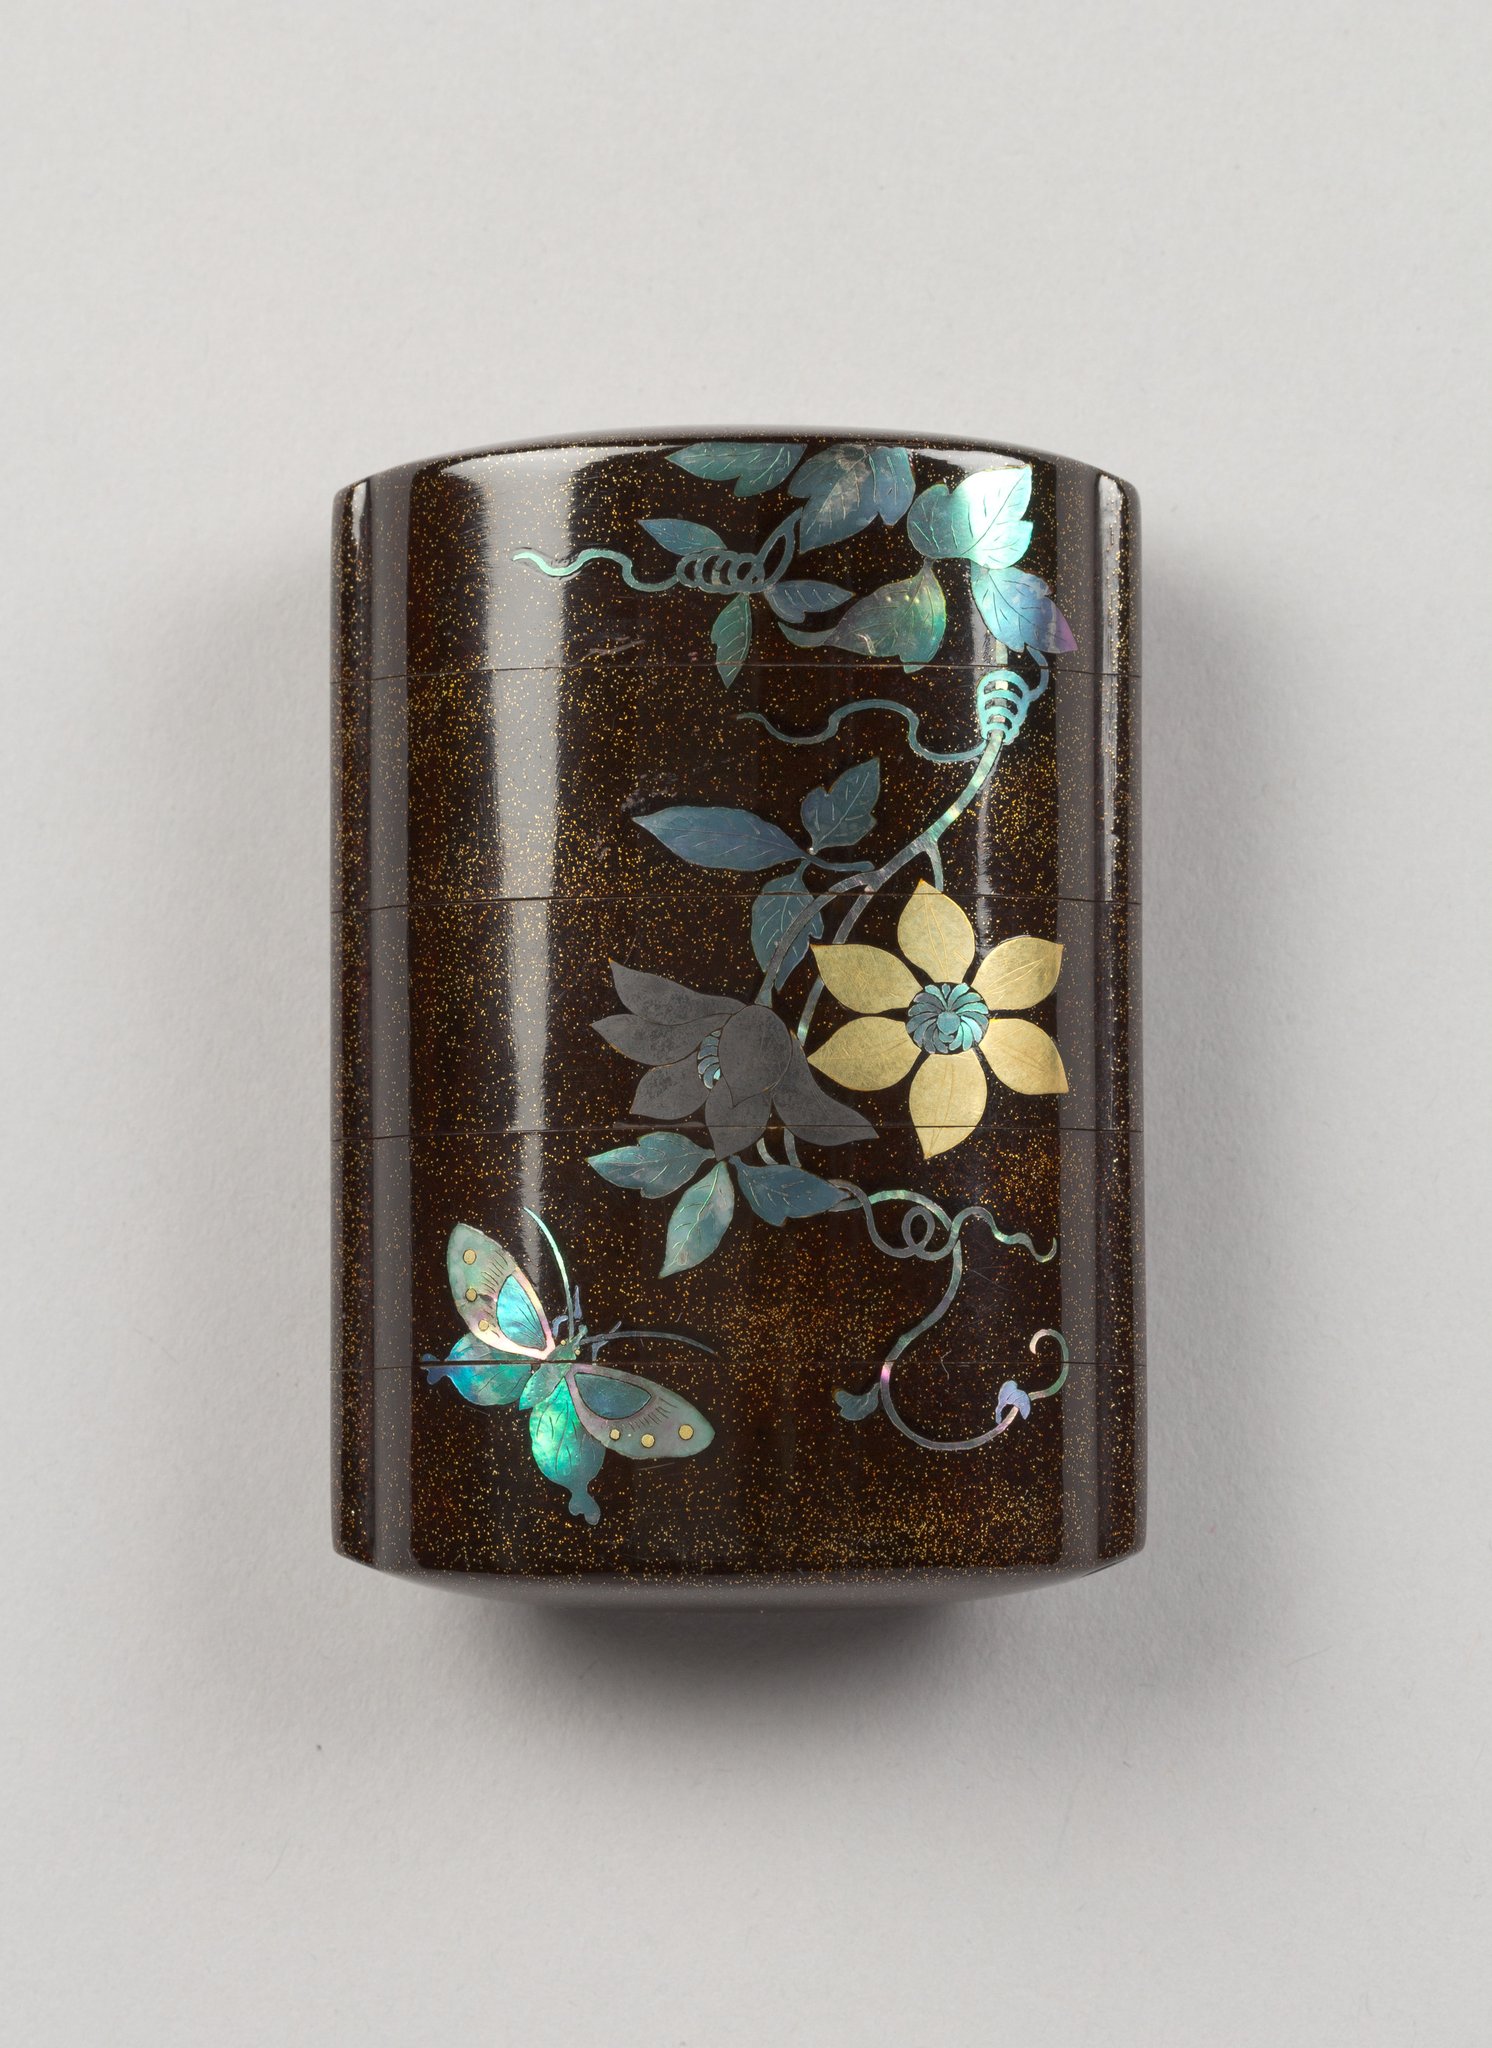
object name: inrō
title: Case (Inrō) with Design of Butterflies in Flight above Flowering Clematis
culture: japanese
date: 1801-1900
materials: gold foil, lacquer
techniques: fundame, inlay, roiro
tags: butterflies,flowers